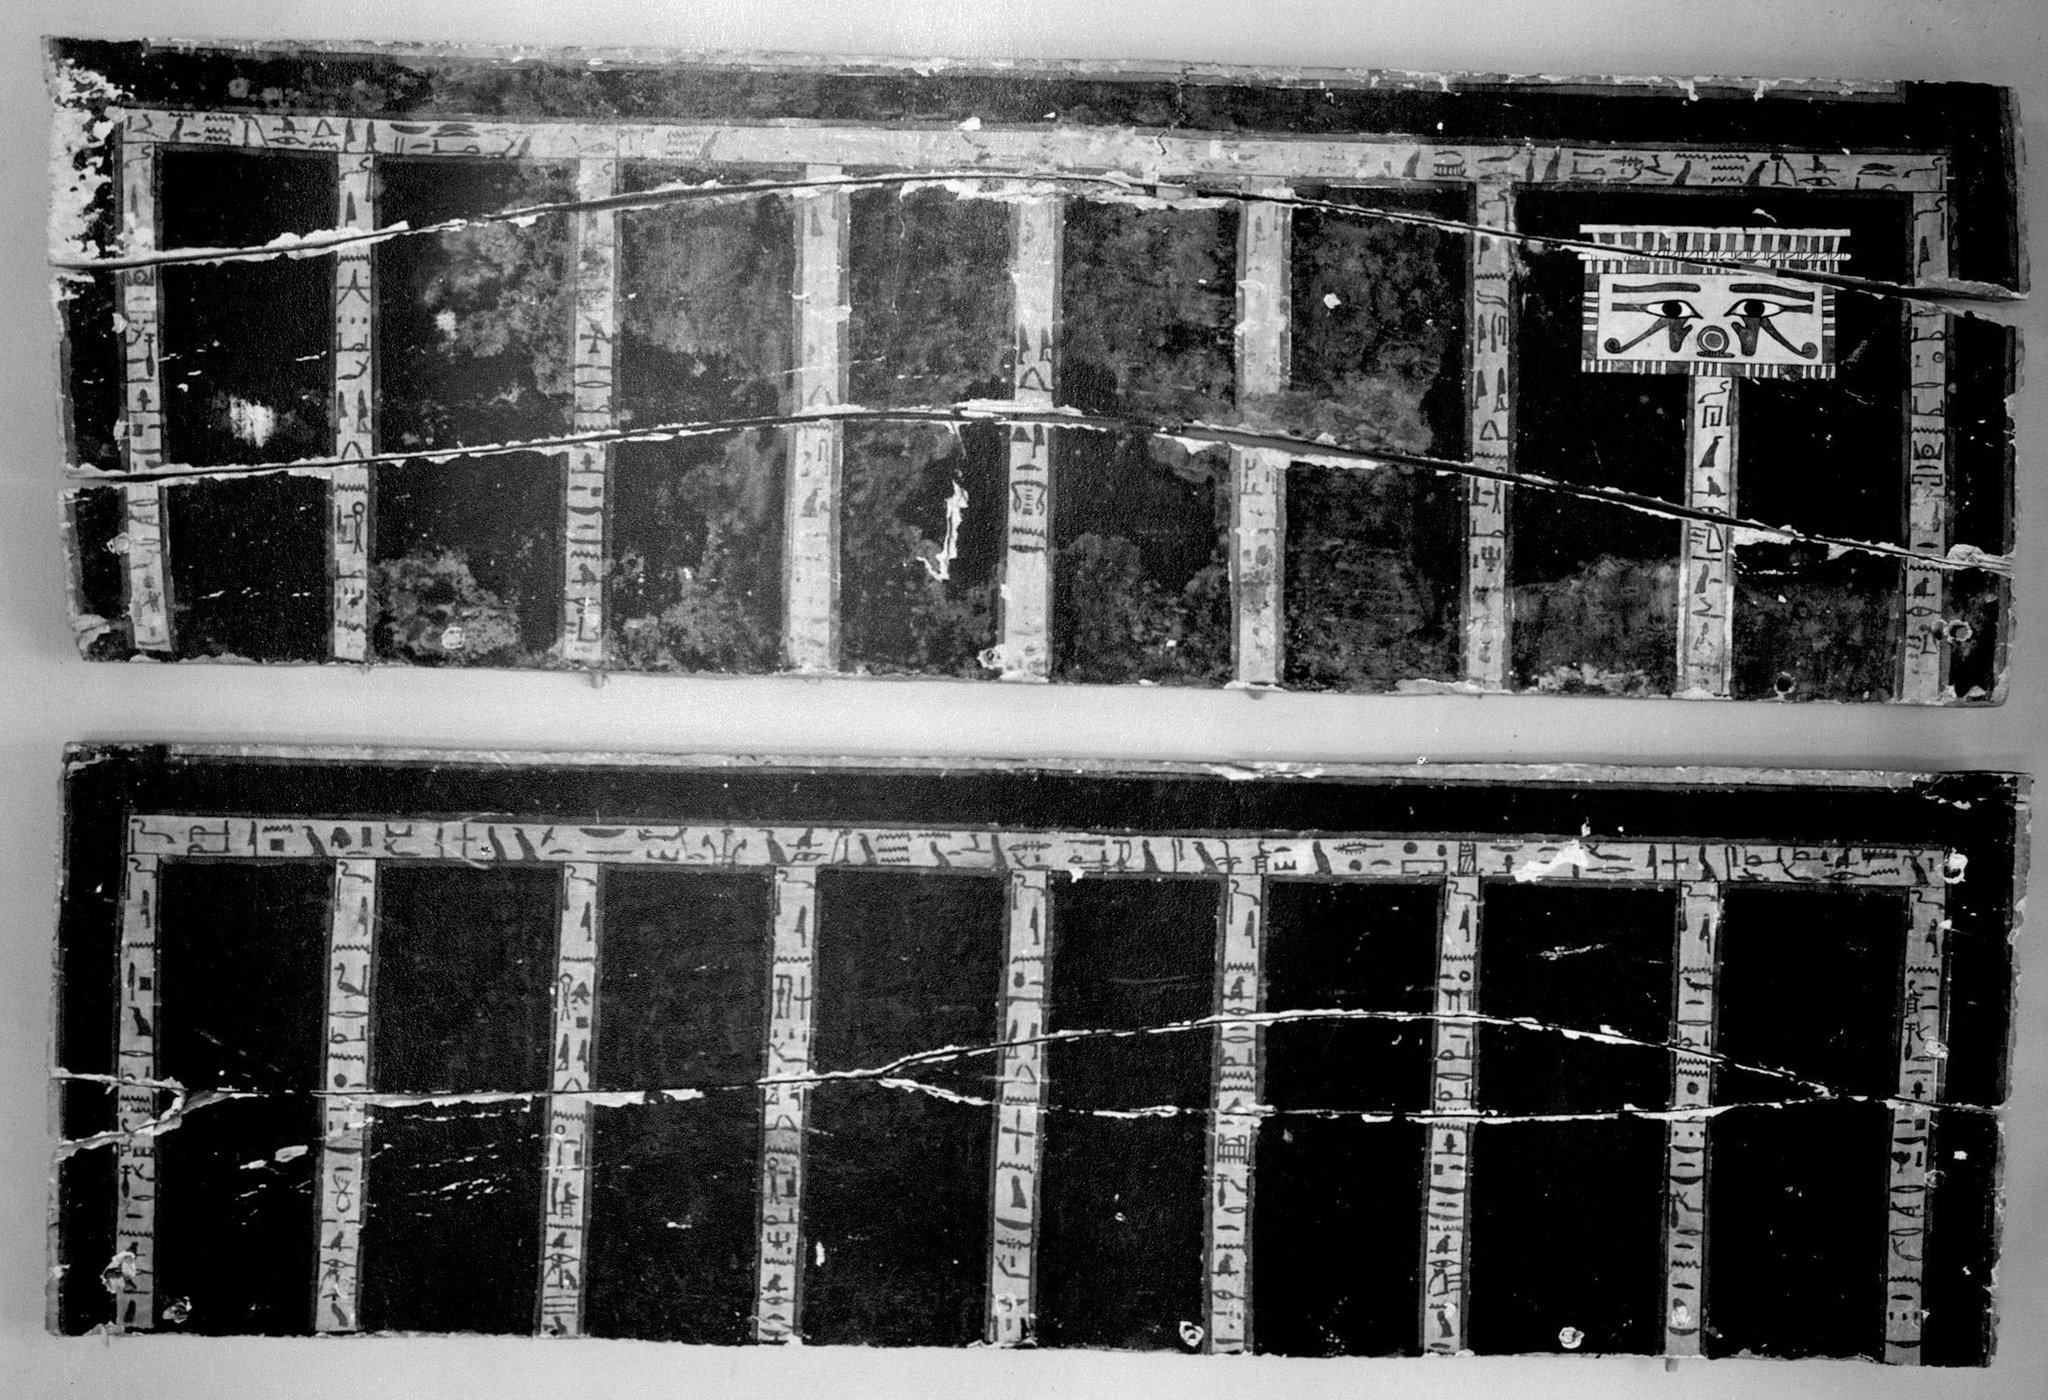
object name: coffin, entemaemsaf, nemtiemsaf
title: Coffin of Nemtiemsaf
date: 1802-1640 BCE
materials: paint, wood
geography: egypt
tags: coffins